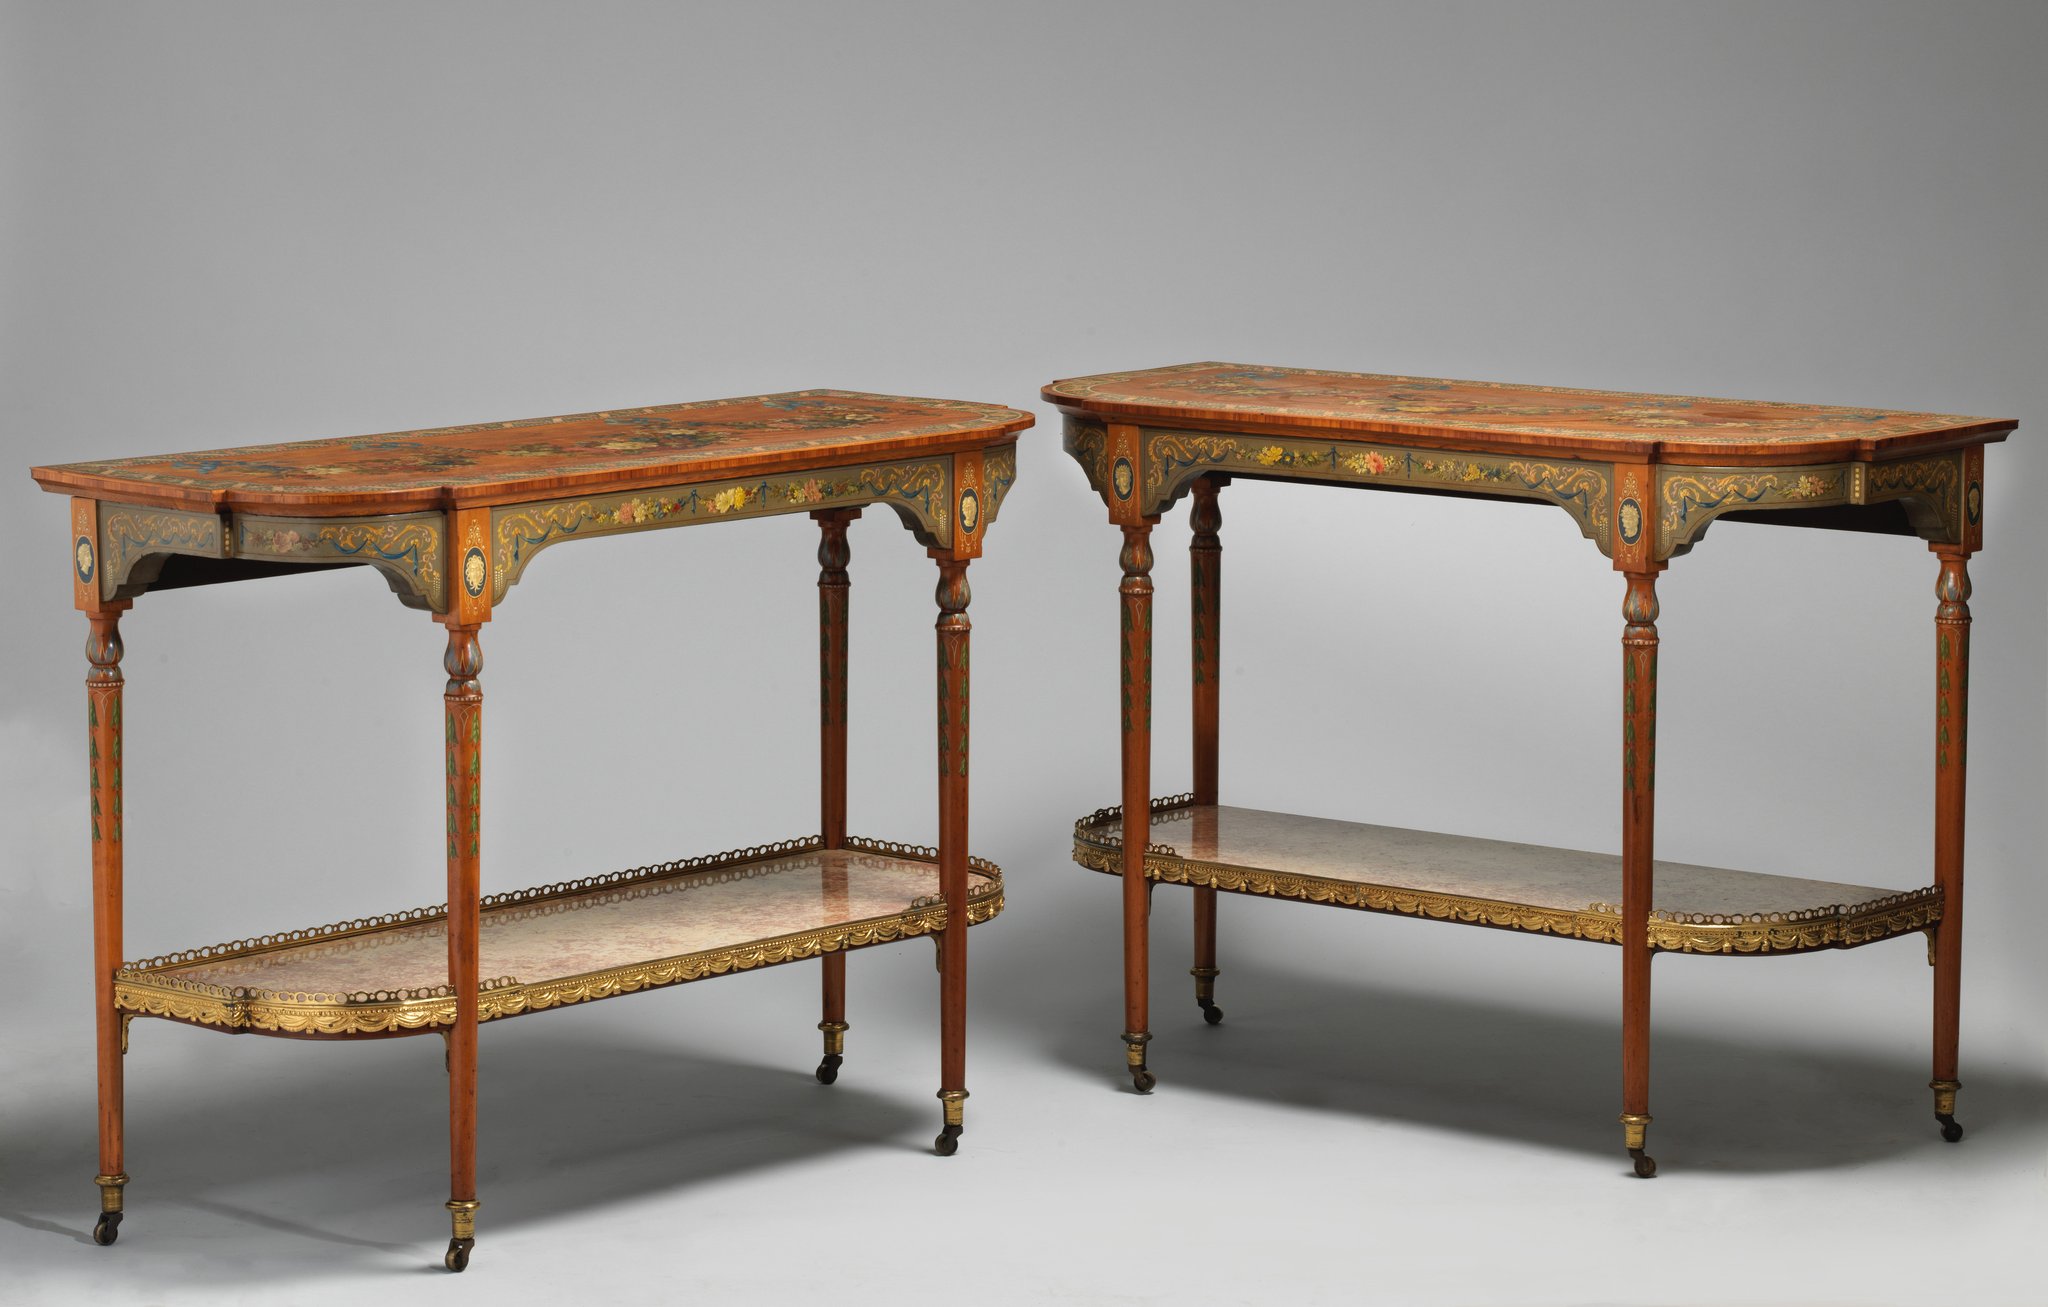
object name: pier table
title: Pair of pier tables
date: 1790-1800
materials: wood, gilt bronze, marble